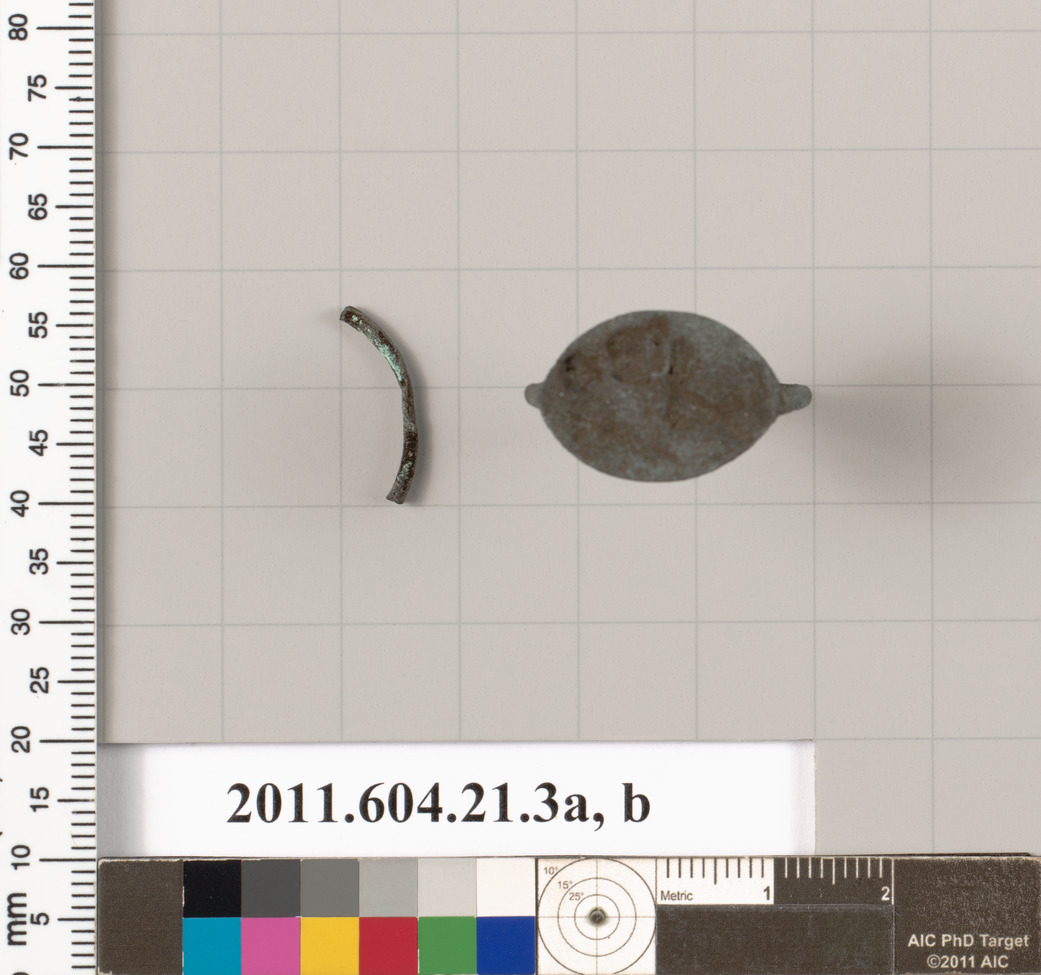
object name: bronze ring fragment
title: Bronze ring fragments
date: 500-301 BCE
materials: bronze